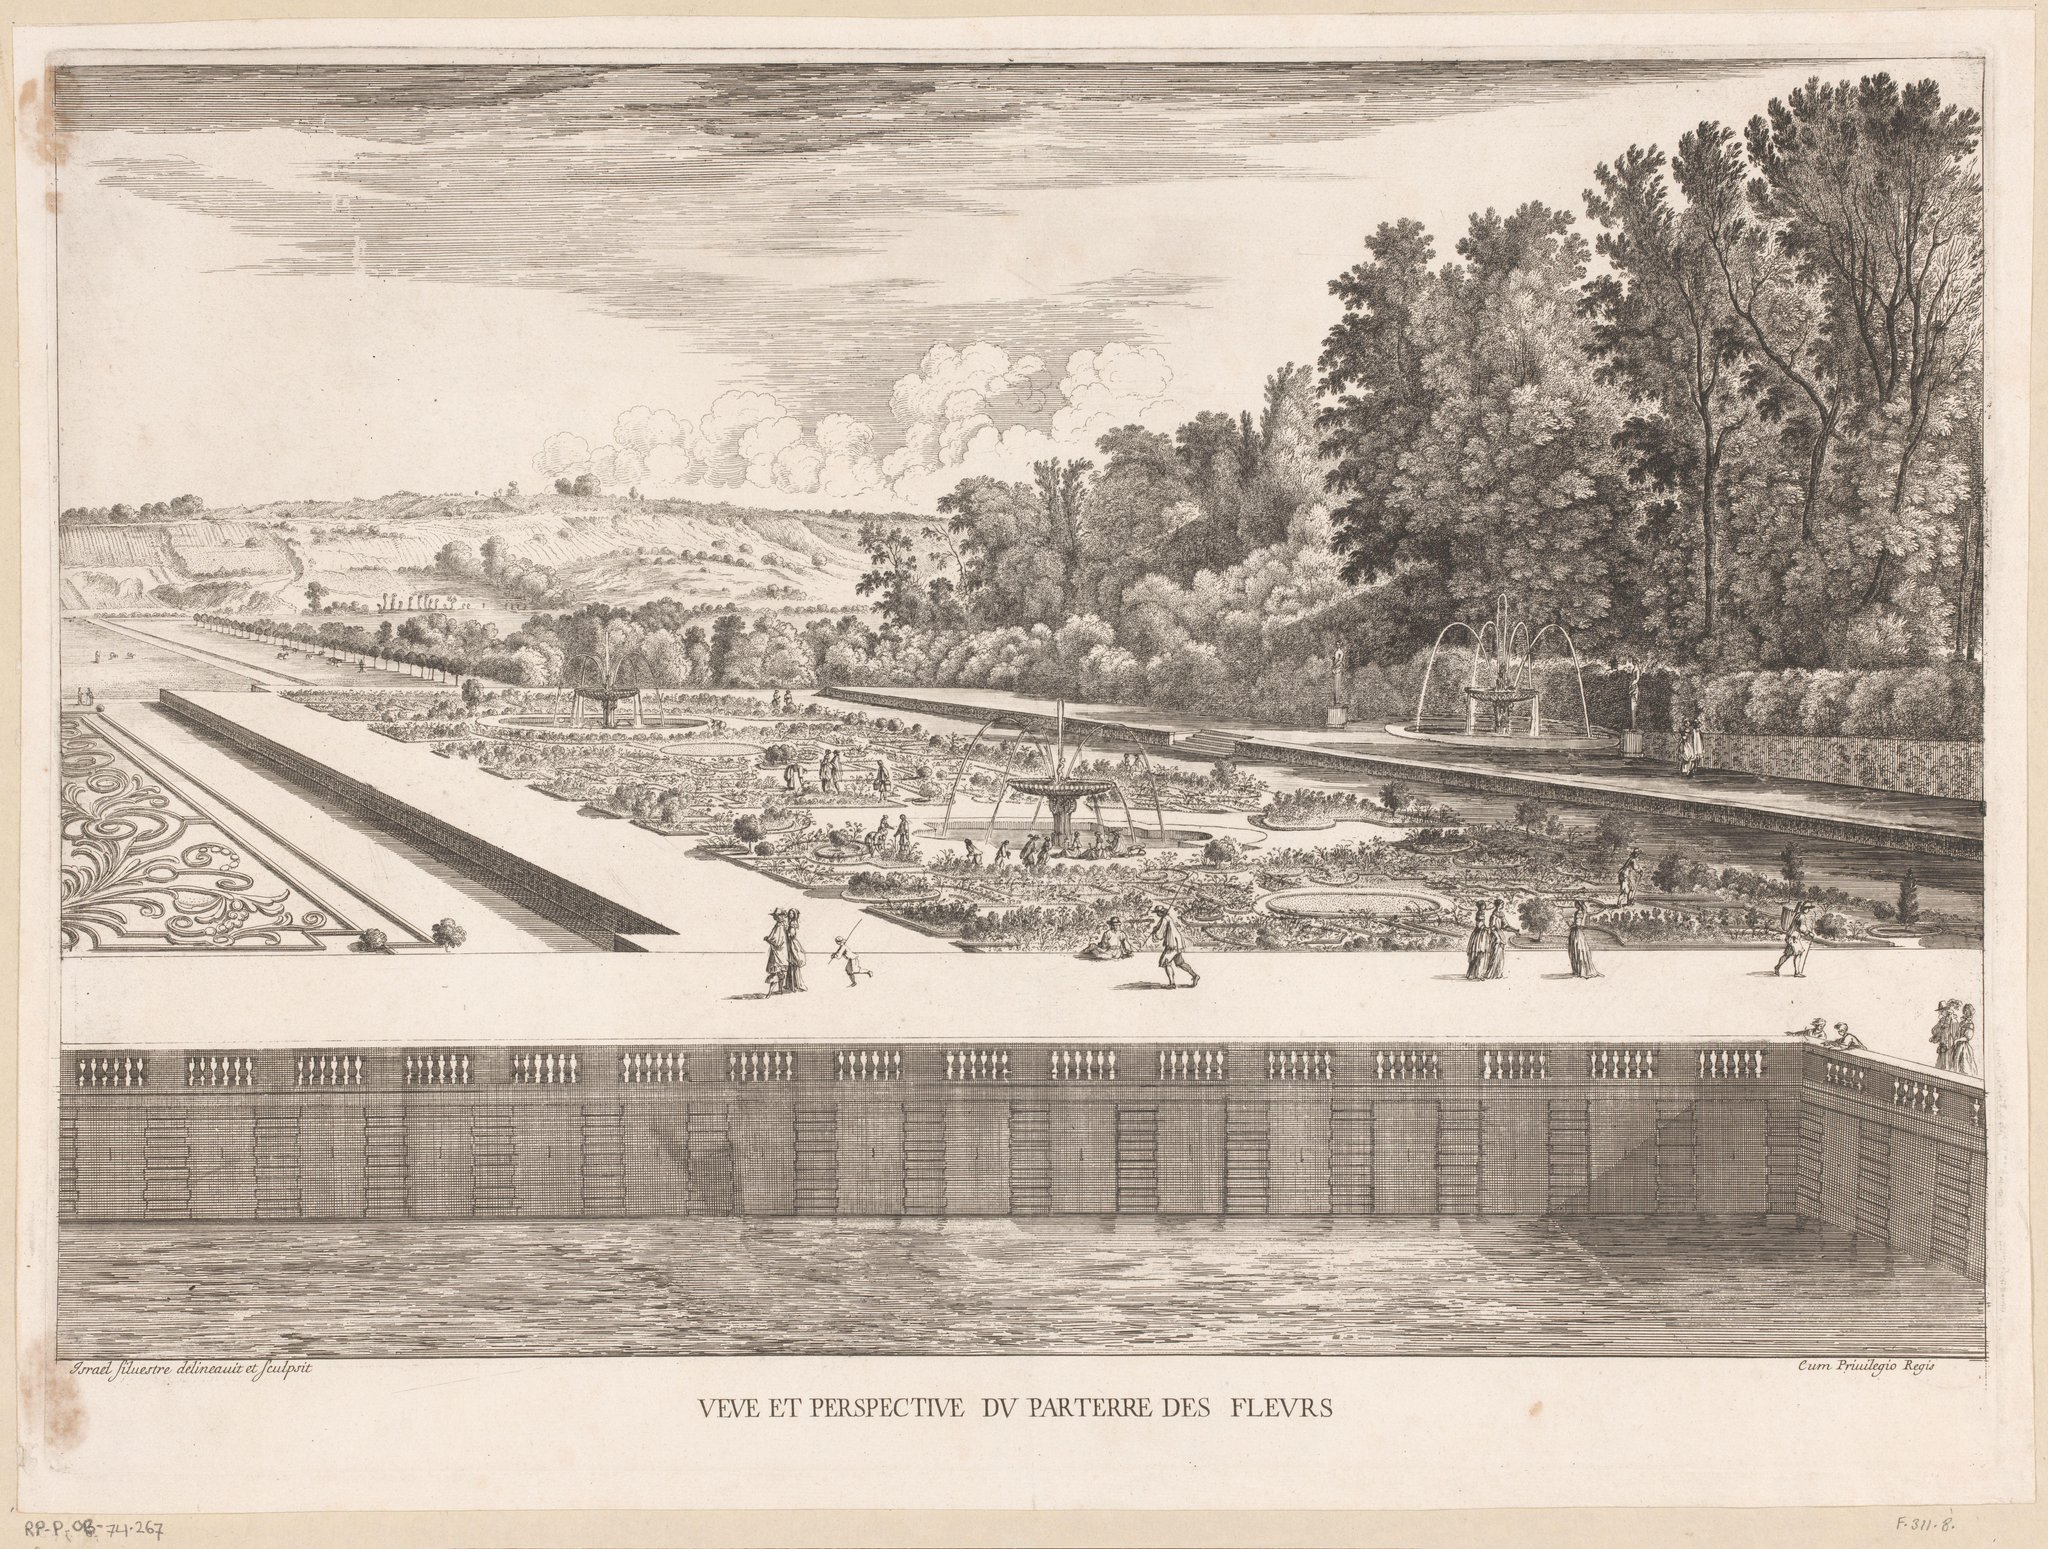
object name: print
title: Uitzicht over bloembedden in de tuinen van Vaux-le-Vicomte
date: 1631-1691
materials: paper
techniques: engraving, etching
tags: garden fountain, french or architectonic garden; formal garden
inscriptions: collector's mark: Lugt 240